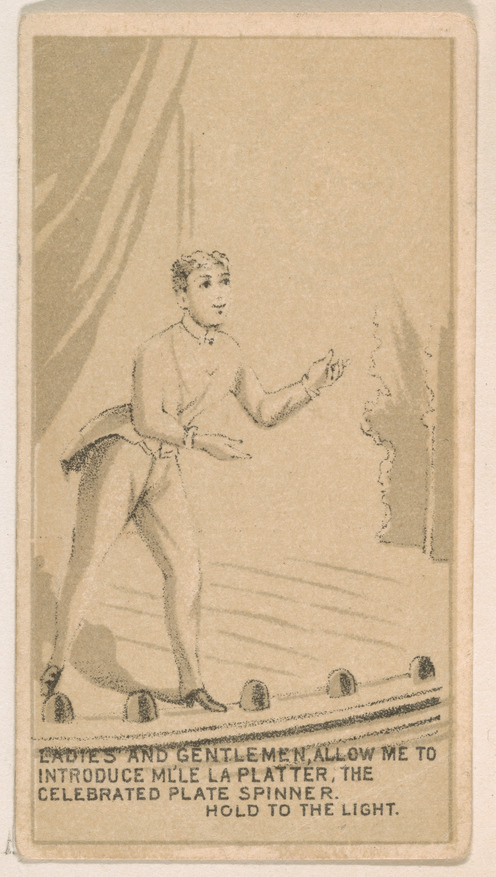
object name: print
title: Ladies and Gentlemen..., from the Magic Changing Cards series (N223) issued by Kinney Tobacco Company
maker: kinney brothers tobacco company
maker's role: publisher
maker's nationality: american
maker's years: 1869-2011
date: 1889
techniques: color lithograph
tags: men,magic